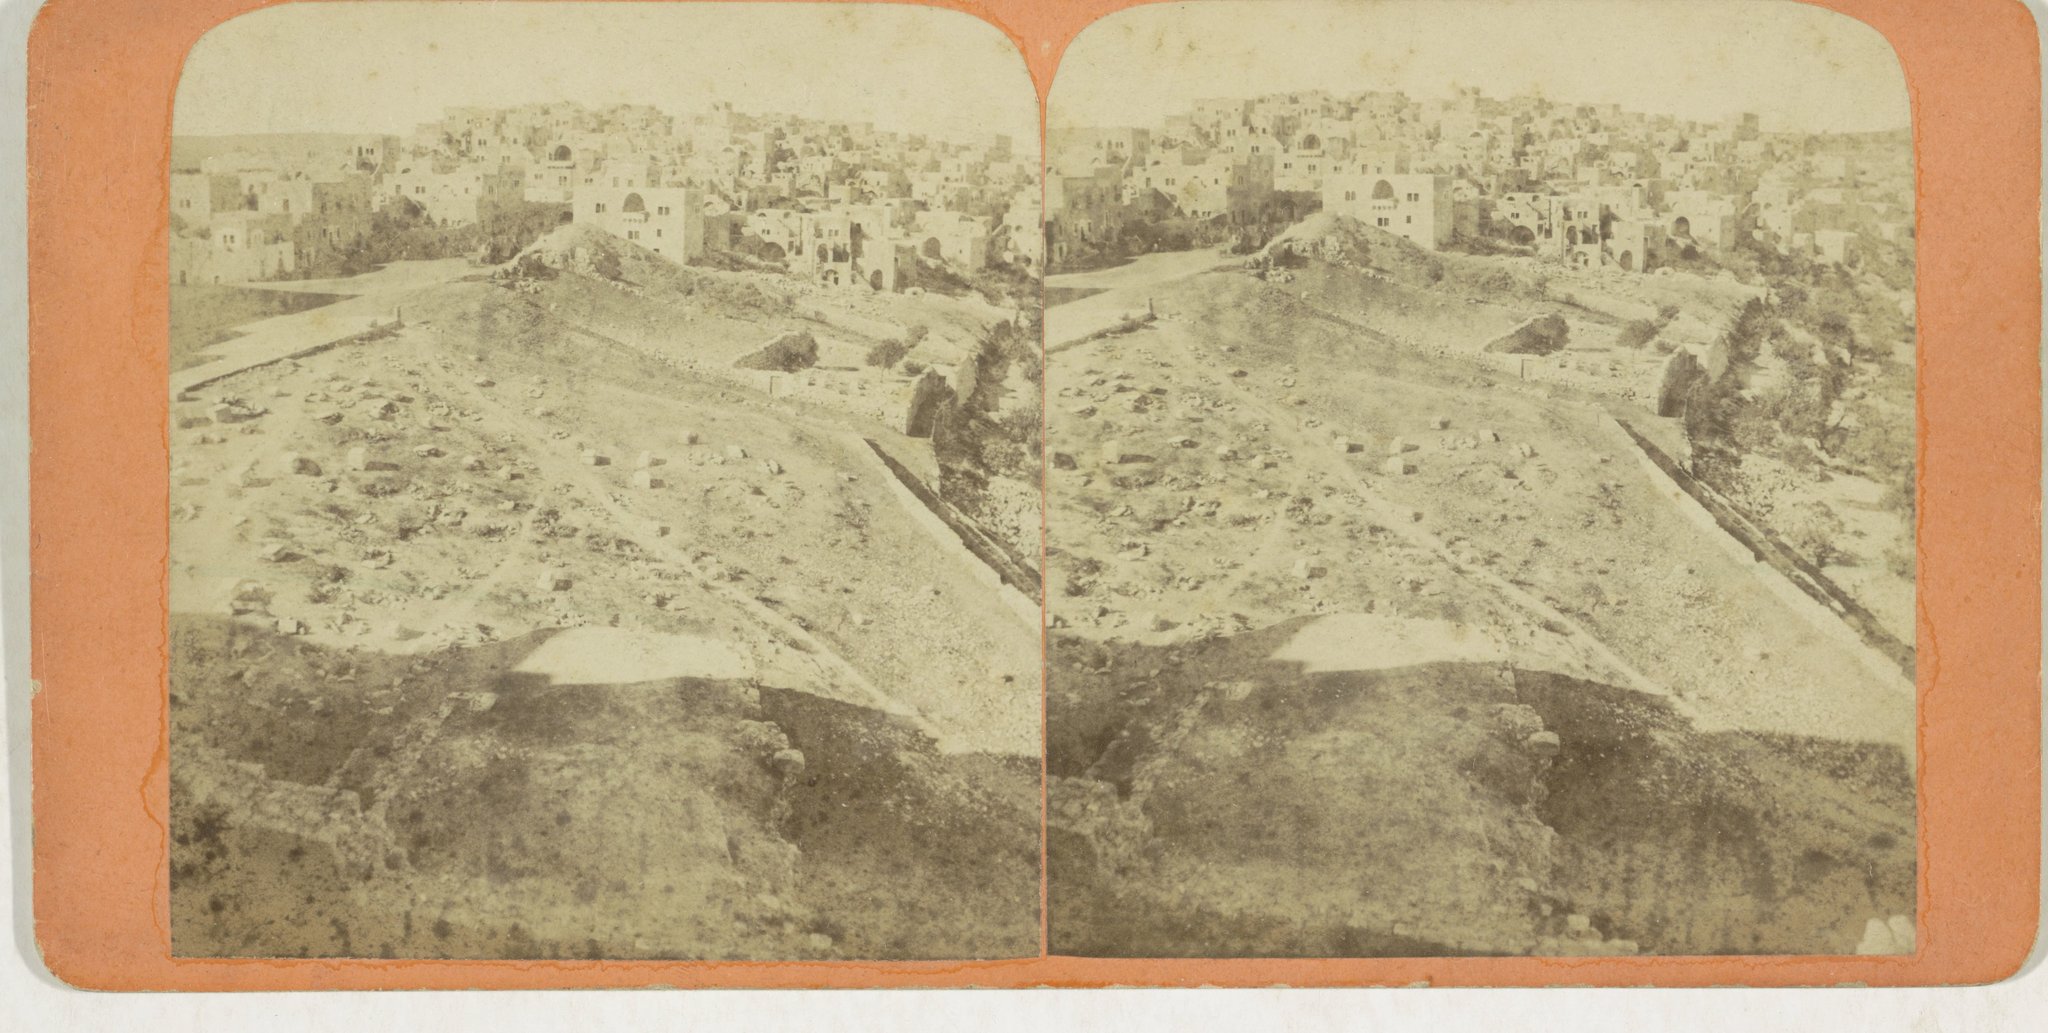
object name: stereograph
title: Vue g"ale de Bethleém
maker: Anonymous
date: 1868-1890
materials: cardboard, paper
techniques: albumen print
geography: bethlehem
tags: city-view in general; 'veduta'